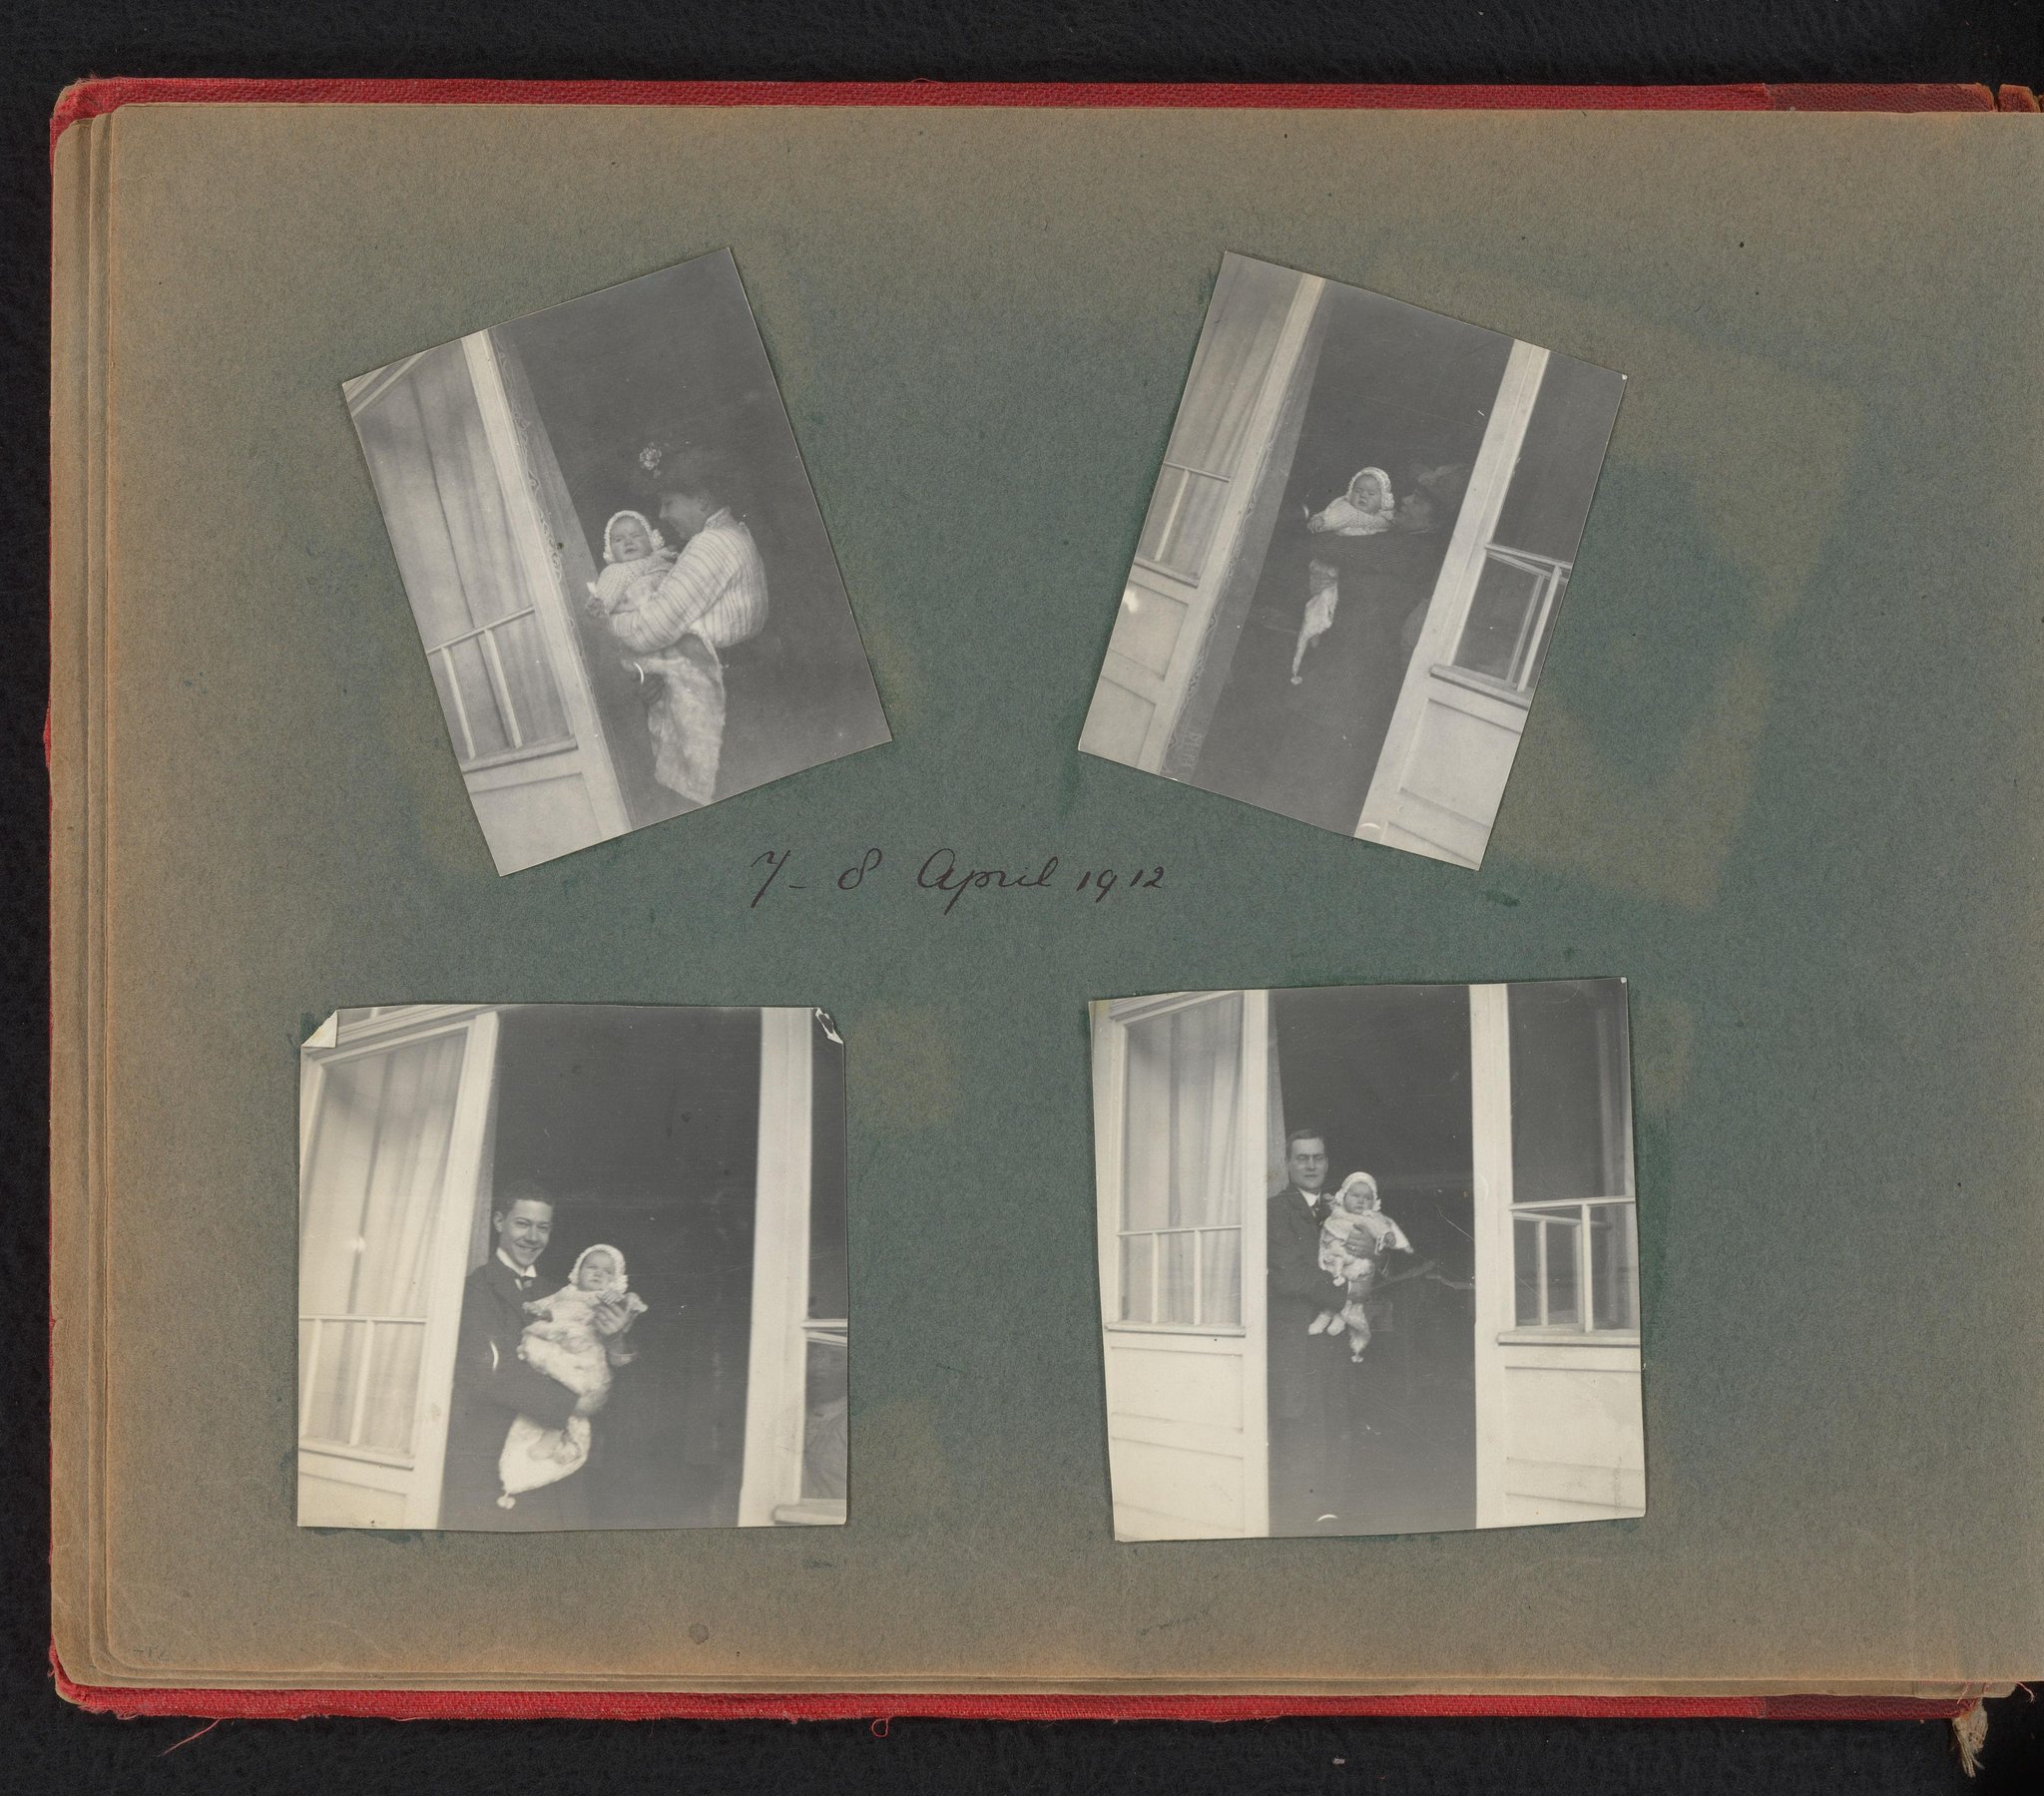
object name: album leaf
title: 7-8 april 1912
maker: charlotte alida boelen-matthes (lot)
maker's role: amateurfotograaf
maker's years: 1889-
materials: paper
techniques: gelatin silver print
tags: thailand, eva charlotte pennink-boelen, charlotte alida boelen-matthes (lot), joan gerard boelen, infant, baby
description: Deze foto's zijn onderdeel van een album.